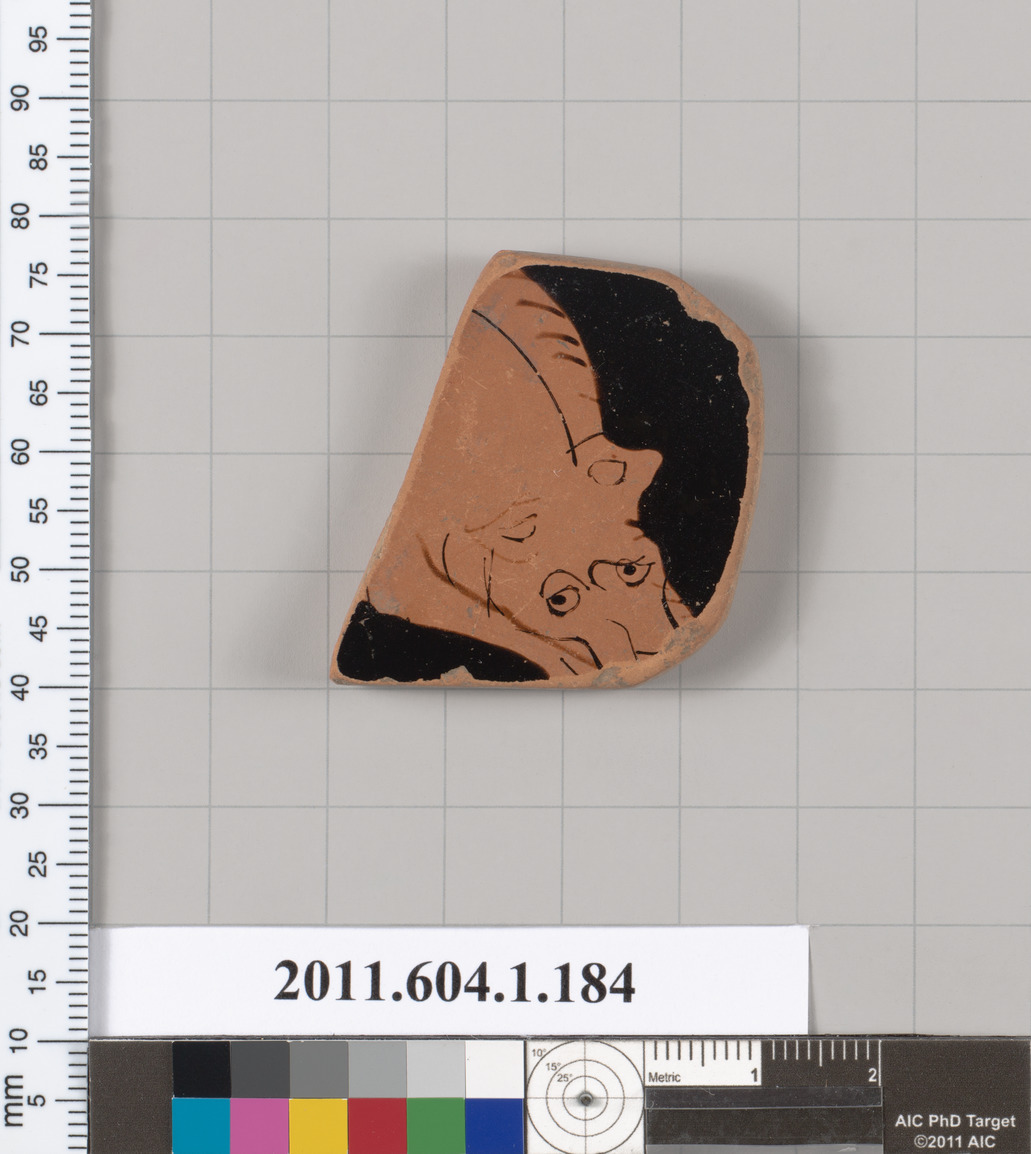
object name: kylix fragment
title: Terracotta fragment of a kylix (drinking cup)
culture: greek, attic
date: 475-451 BCE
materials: terracotta